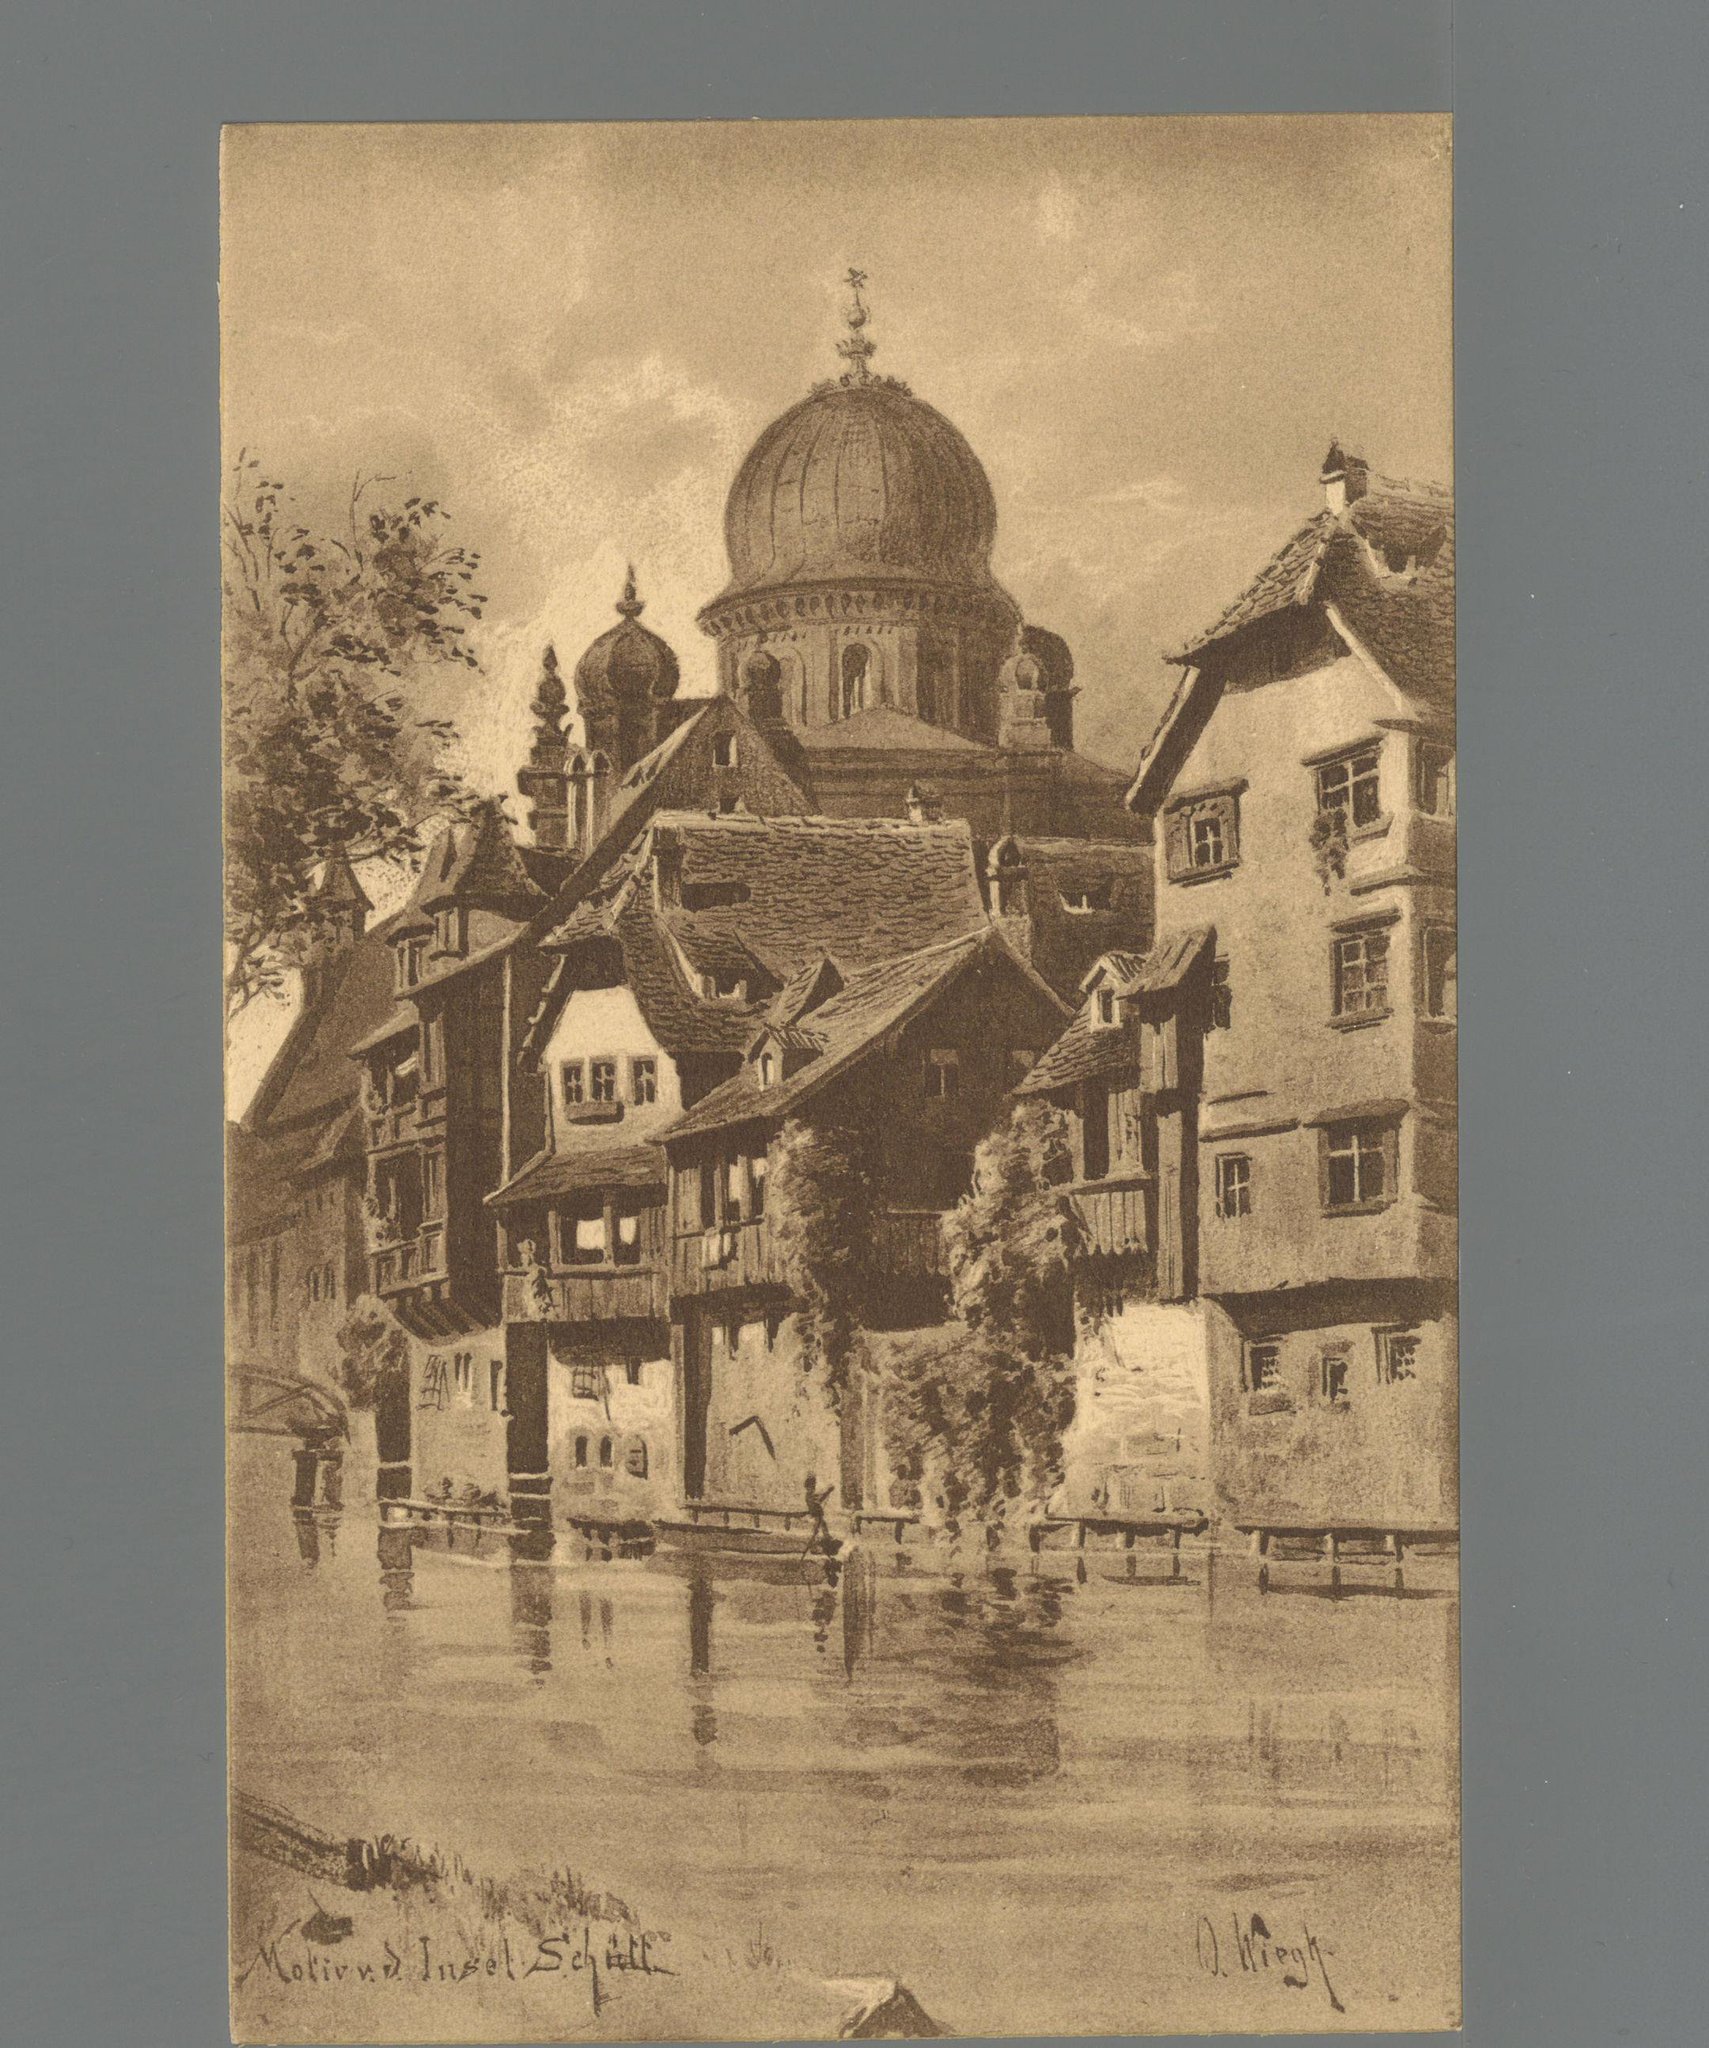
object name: reproduction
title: Nürnberg. Partie an der Insel Schütt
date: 1905-1909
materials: cardboard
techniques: photograph, writing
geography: nuremberg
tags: canals, waters (in city), street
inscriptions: inscription: ‘O. Wienk’